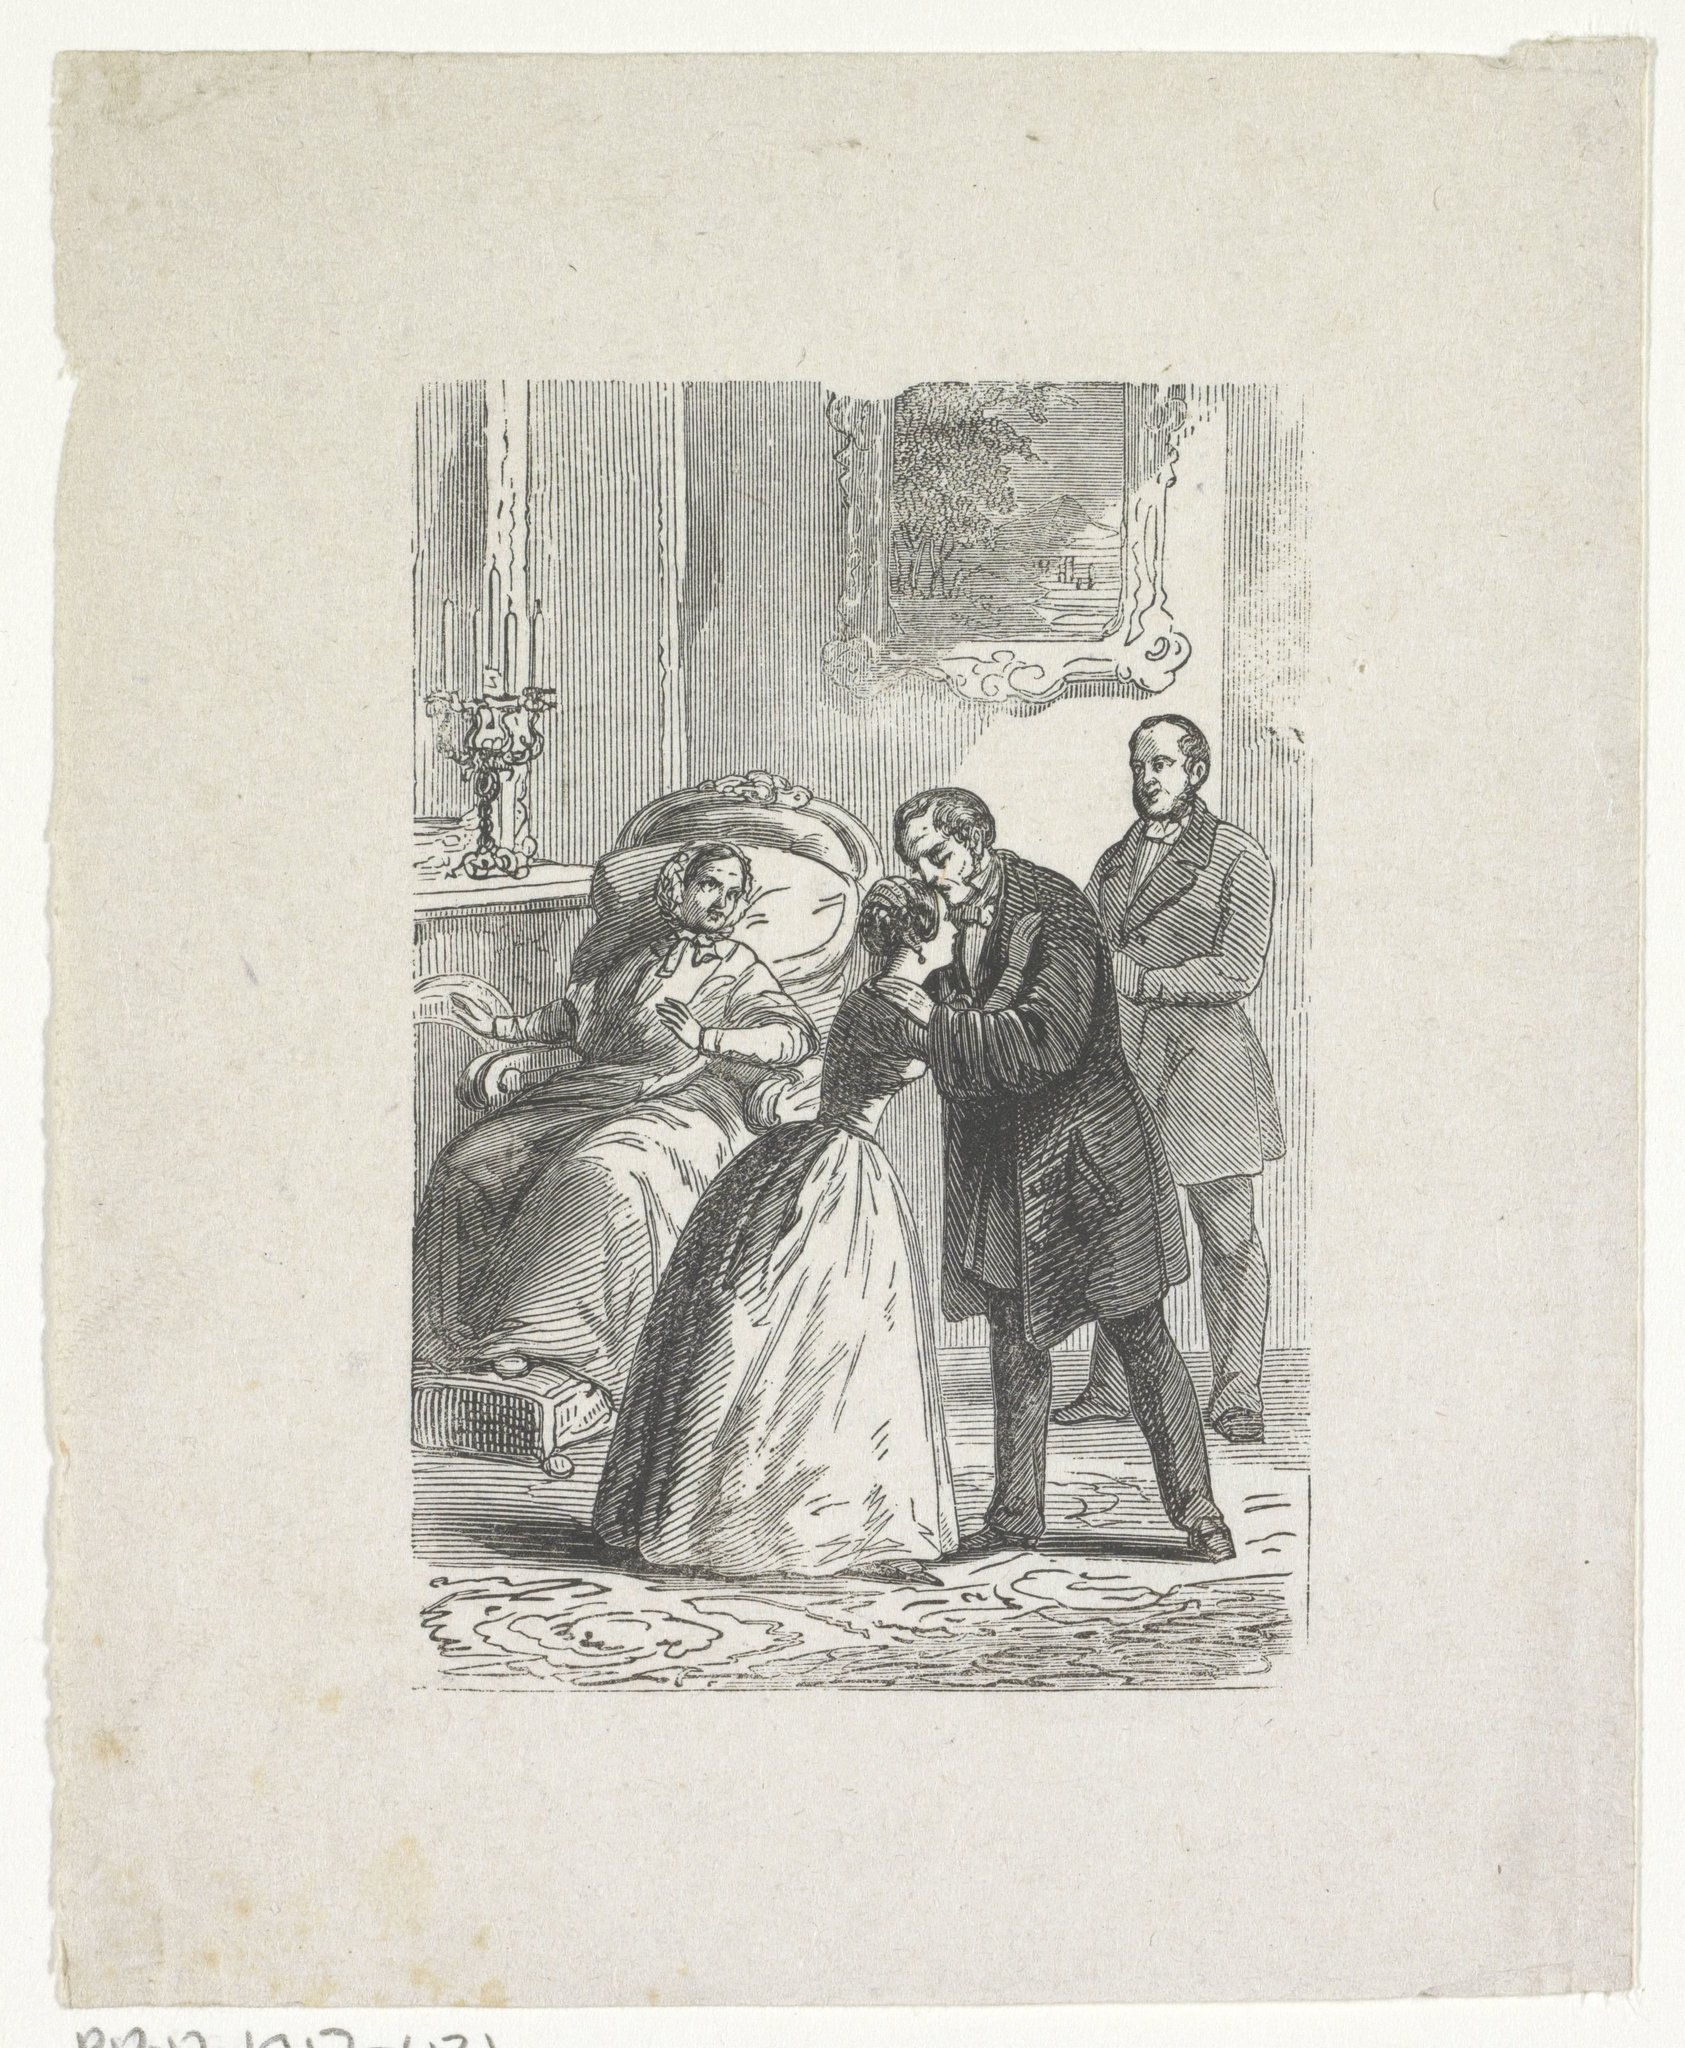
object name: print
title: Interieur met vier figuren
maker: rombertus julianus van arum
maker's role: print maker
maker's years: 1812-1883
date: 1822-1883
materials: paper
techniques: engraving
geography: amsterdam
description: Een vrouw ligt in een stoel en warmt haar hand aan een haard. Een man en een vrouw houden elkaar vast. Een tweede man staat ernaast. Op de achtergrond hangt een schilderij aan de muur en staat een kandelaar op de schouw.